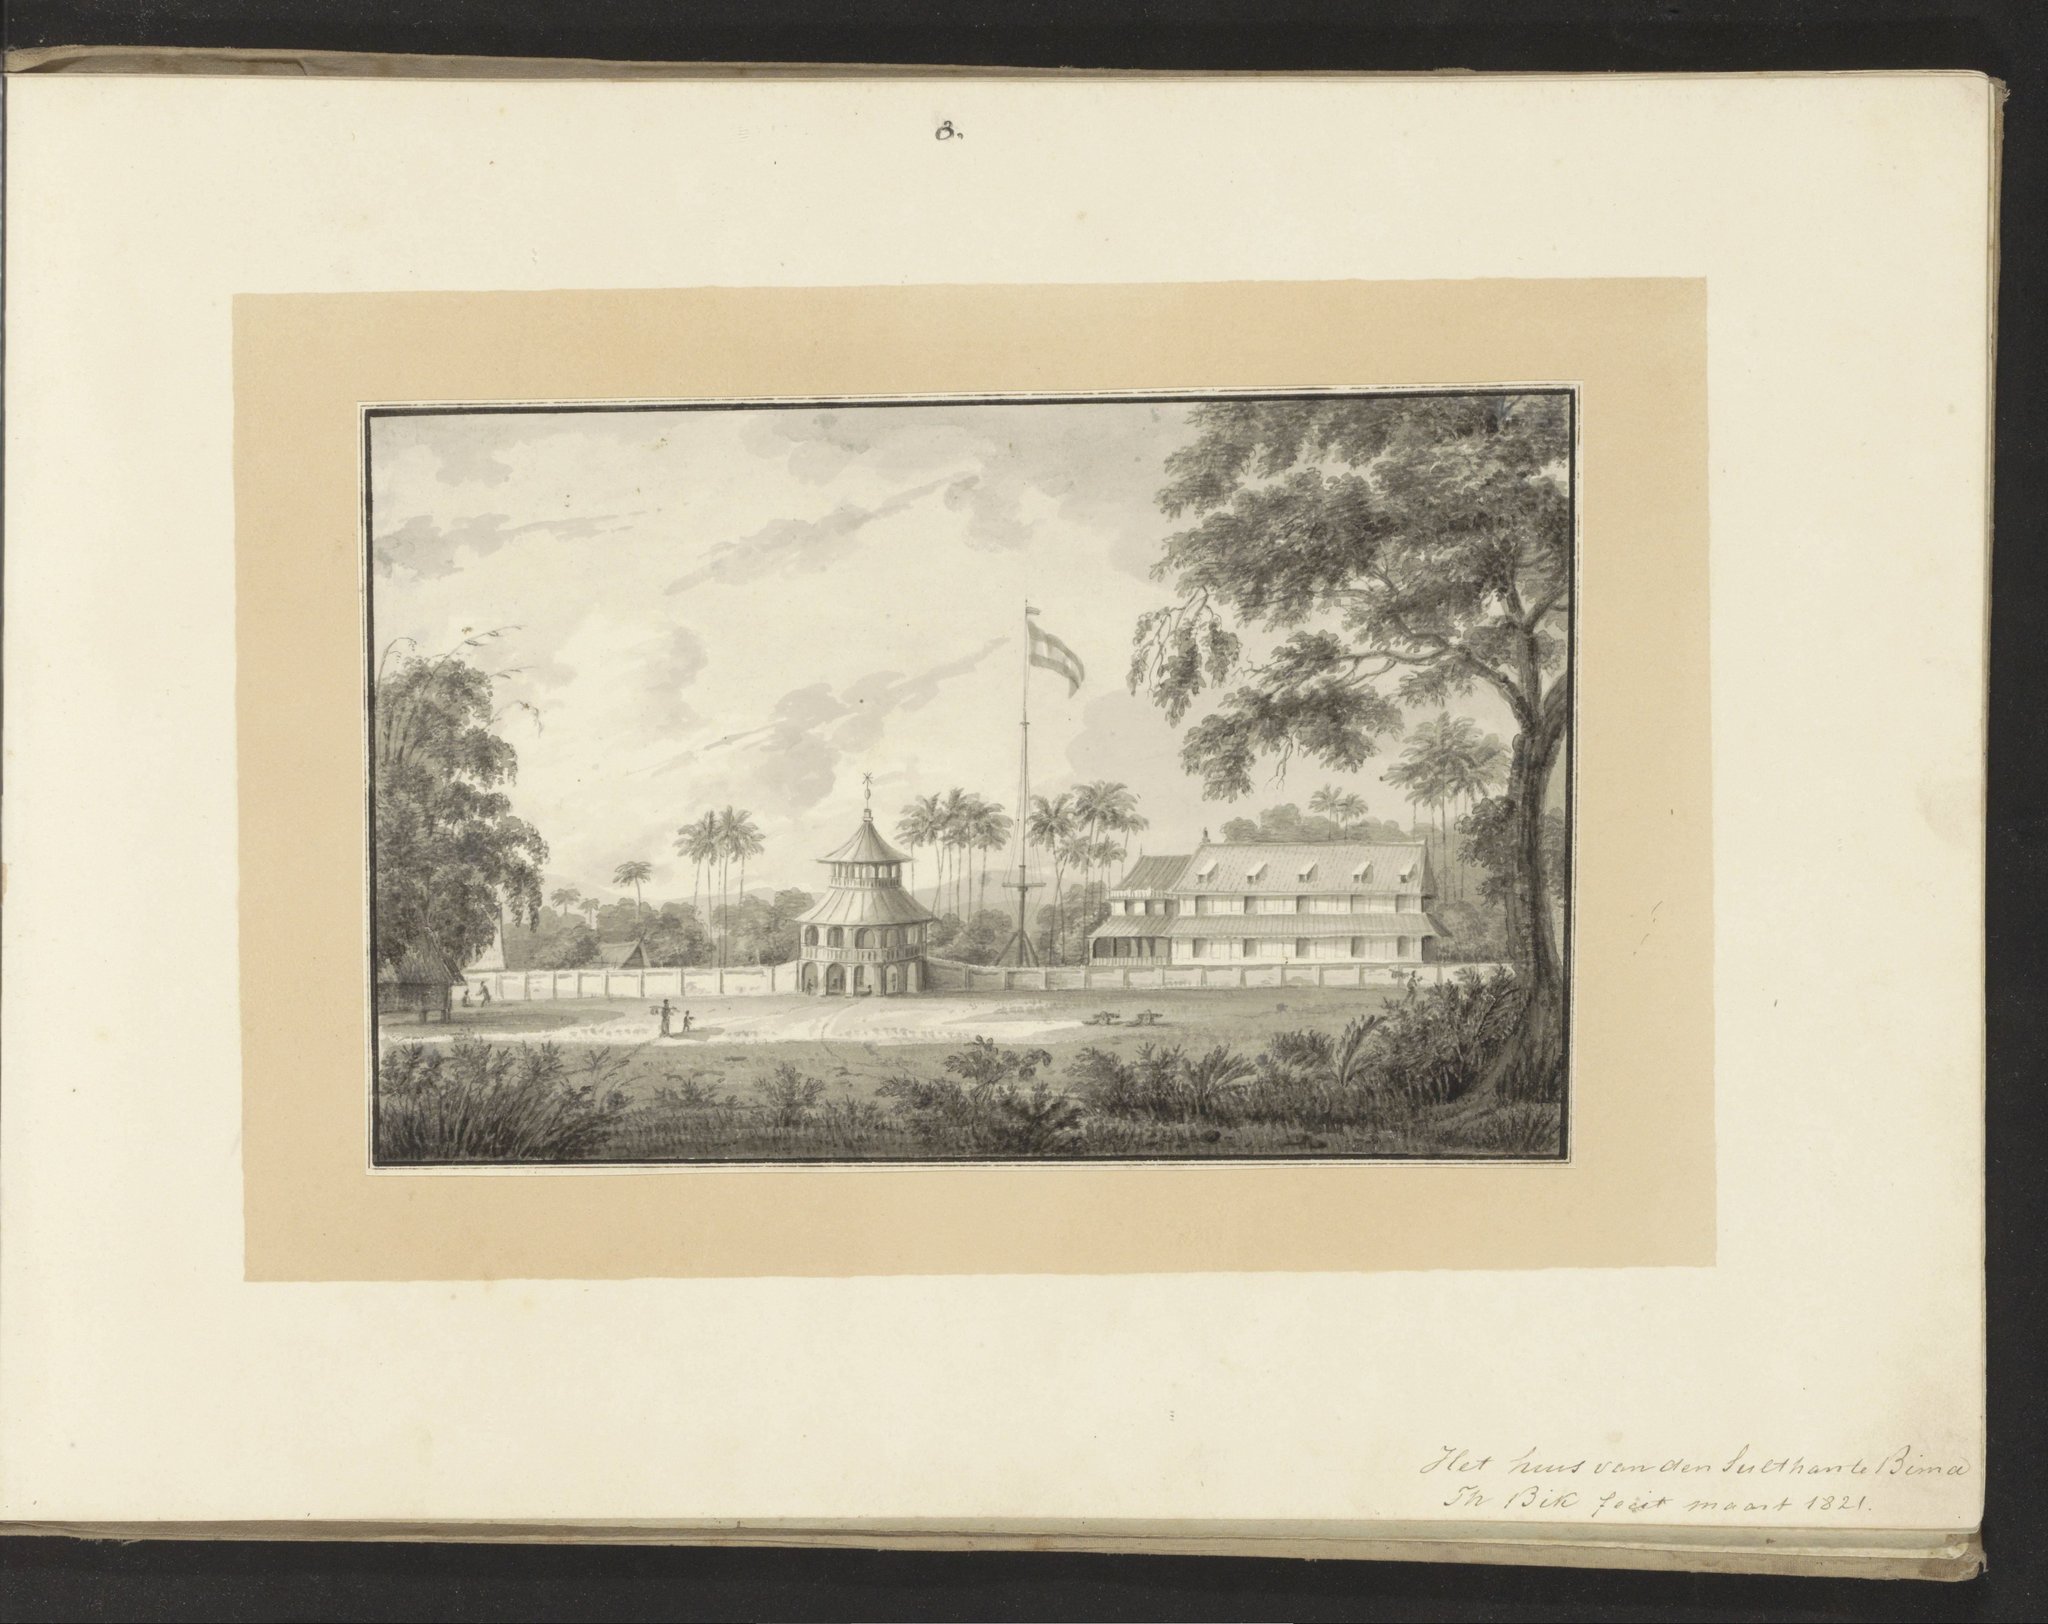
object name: album leaf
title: Huis van de Sultan te Bima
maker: jannes theodorus bik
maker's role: draughtsman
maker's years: 1796-1872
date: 1803-1821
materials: chalk, ink, paper, pencil, watercolor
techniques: brush, pen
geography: bima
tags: country-house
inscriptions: signature and date: ‘Th. Bik fecit maart 1821.’, annotation: ‘Het huis van den Sulthan te Bima’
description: Blad 3 uit een album met 14 tekeningen en een prent.